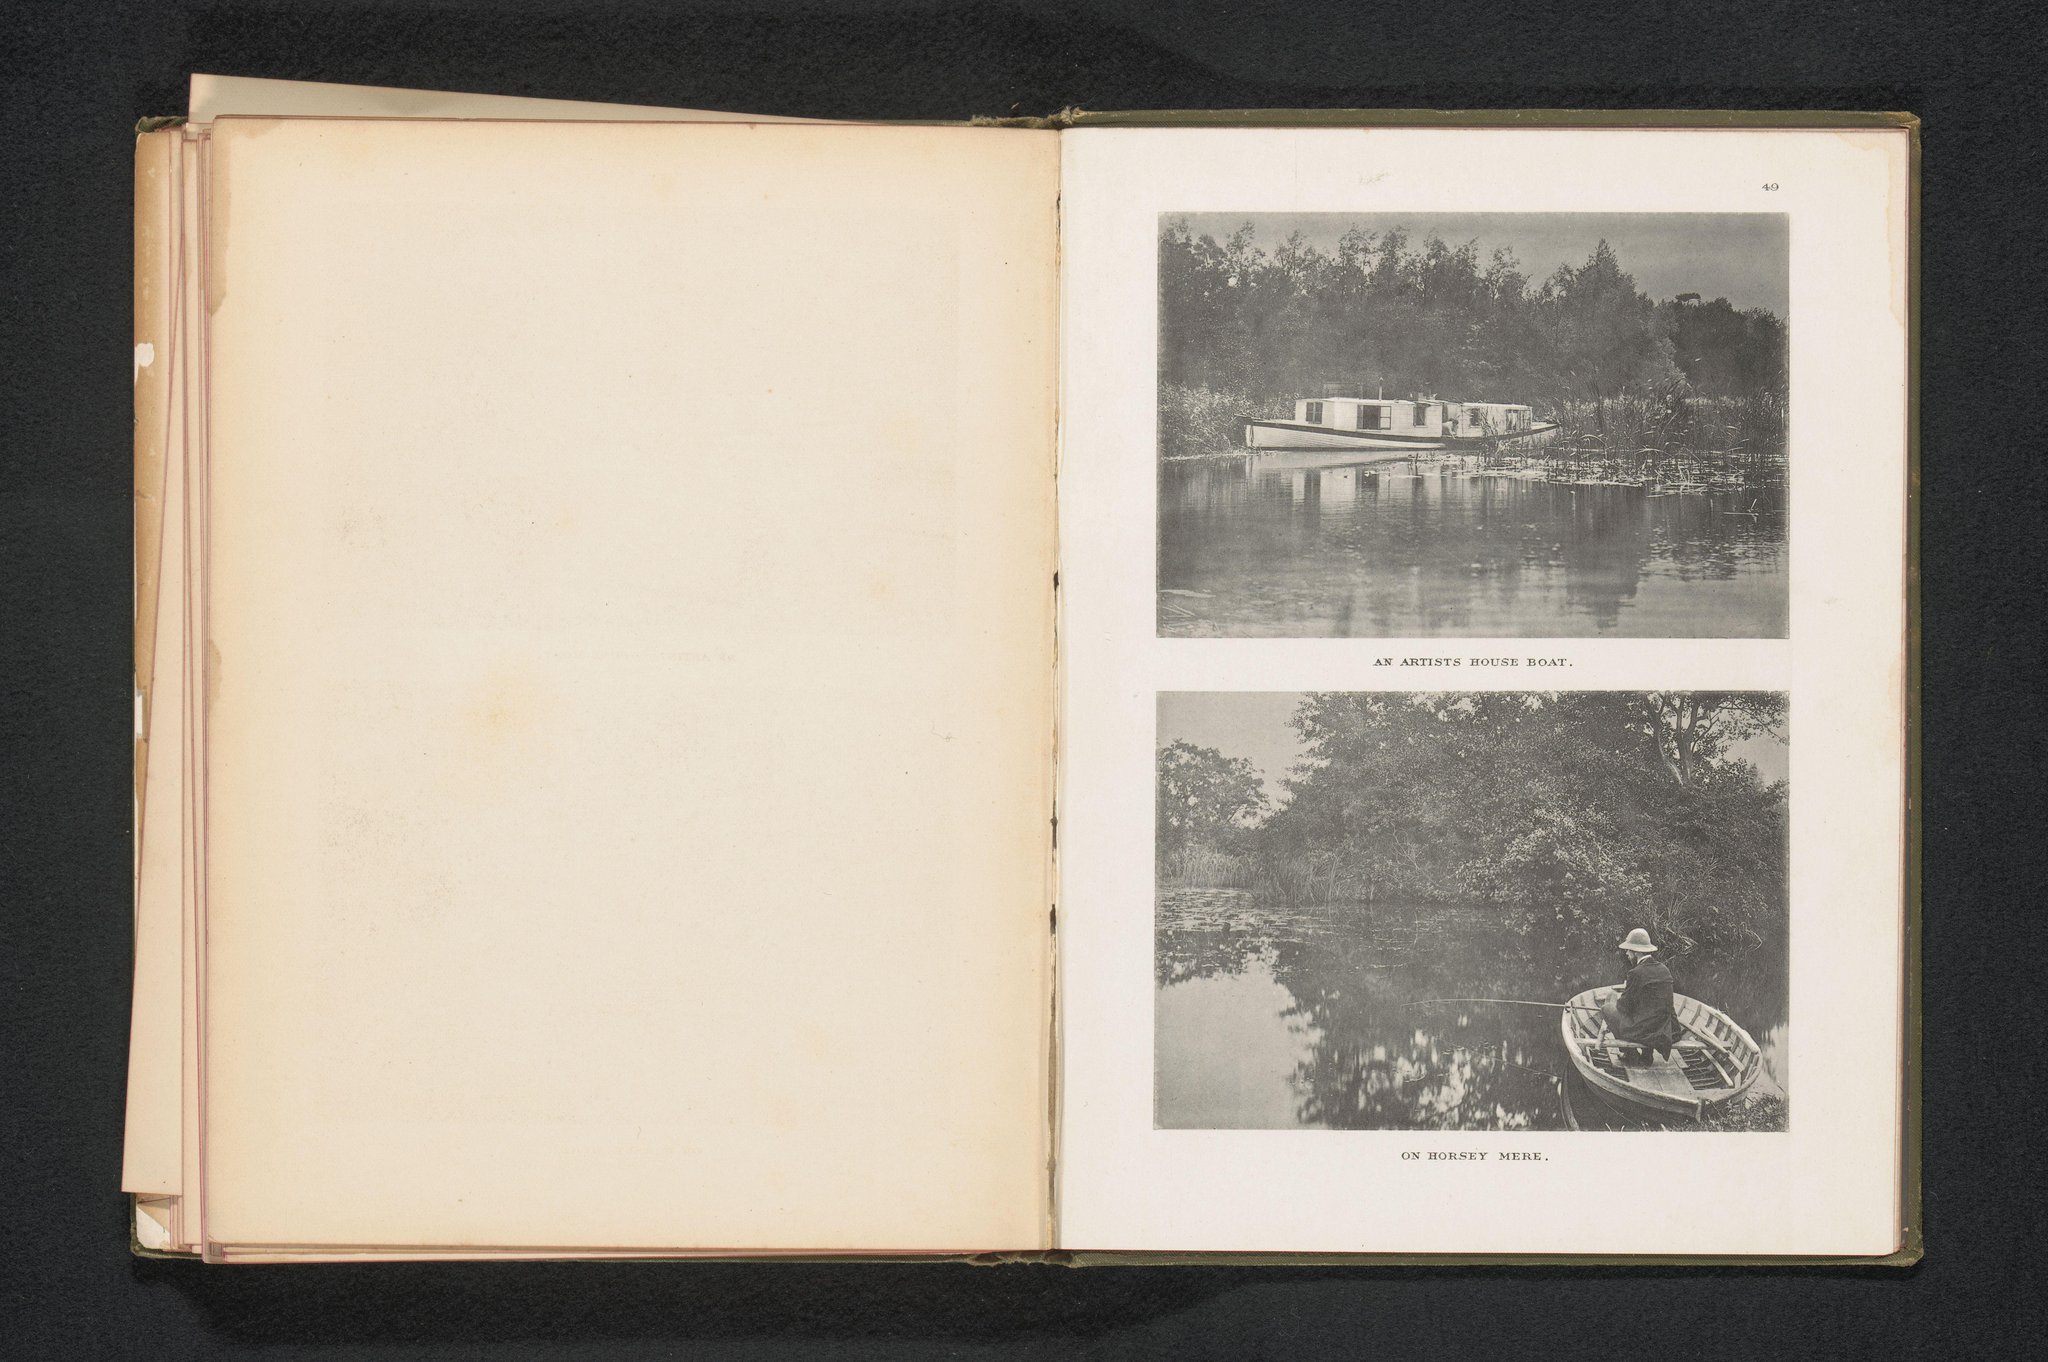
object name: photomechanical print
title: Woonboot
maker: john payne jennings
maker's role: fotograaf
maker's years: 1843-1926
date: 1886-1891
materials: paper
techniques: photograph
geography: surrey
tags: landscapes with waters, waterscapes, seascapes (in the temperate zone), houseboat